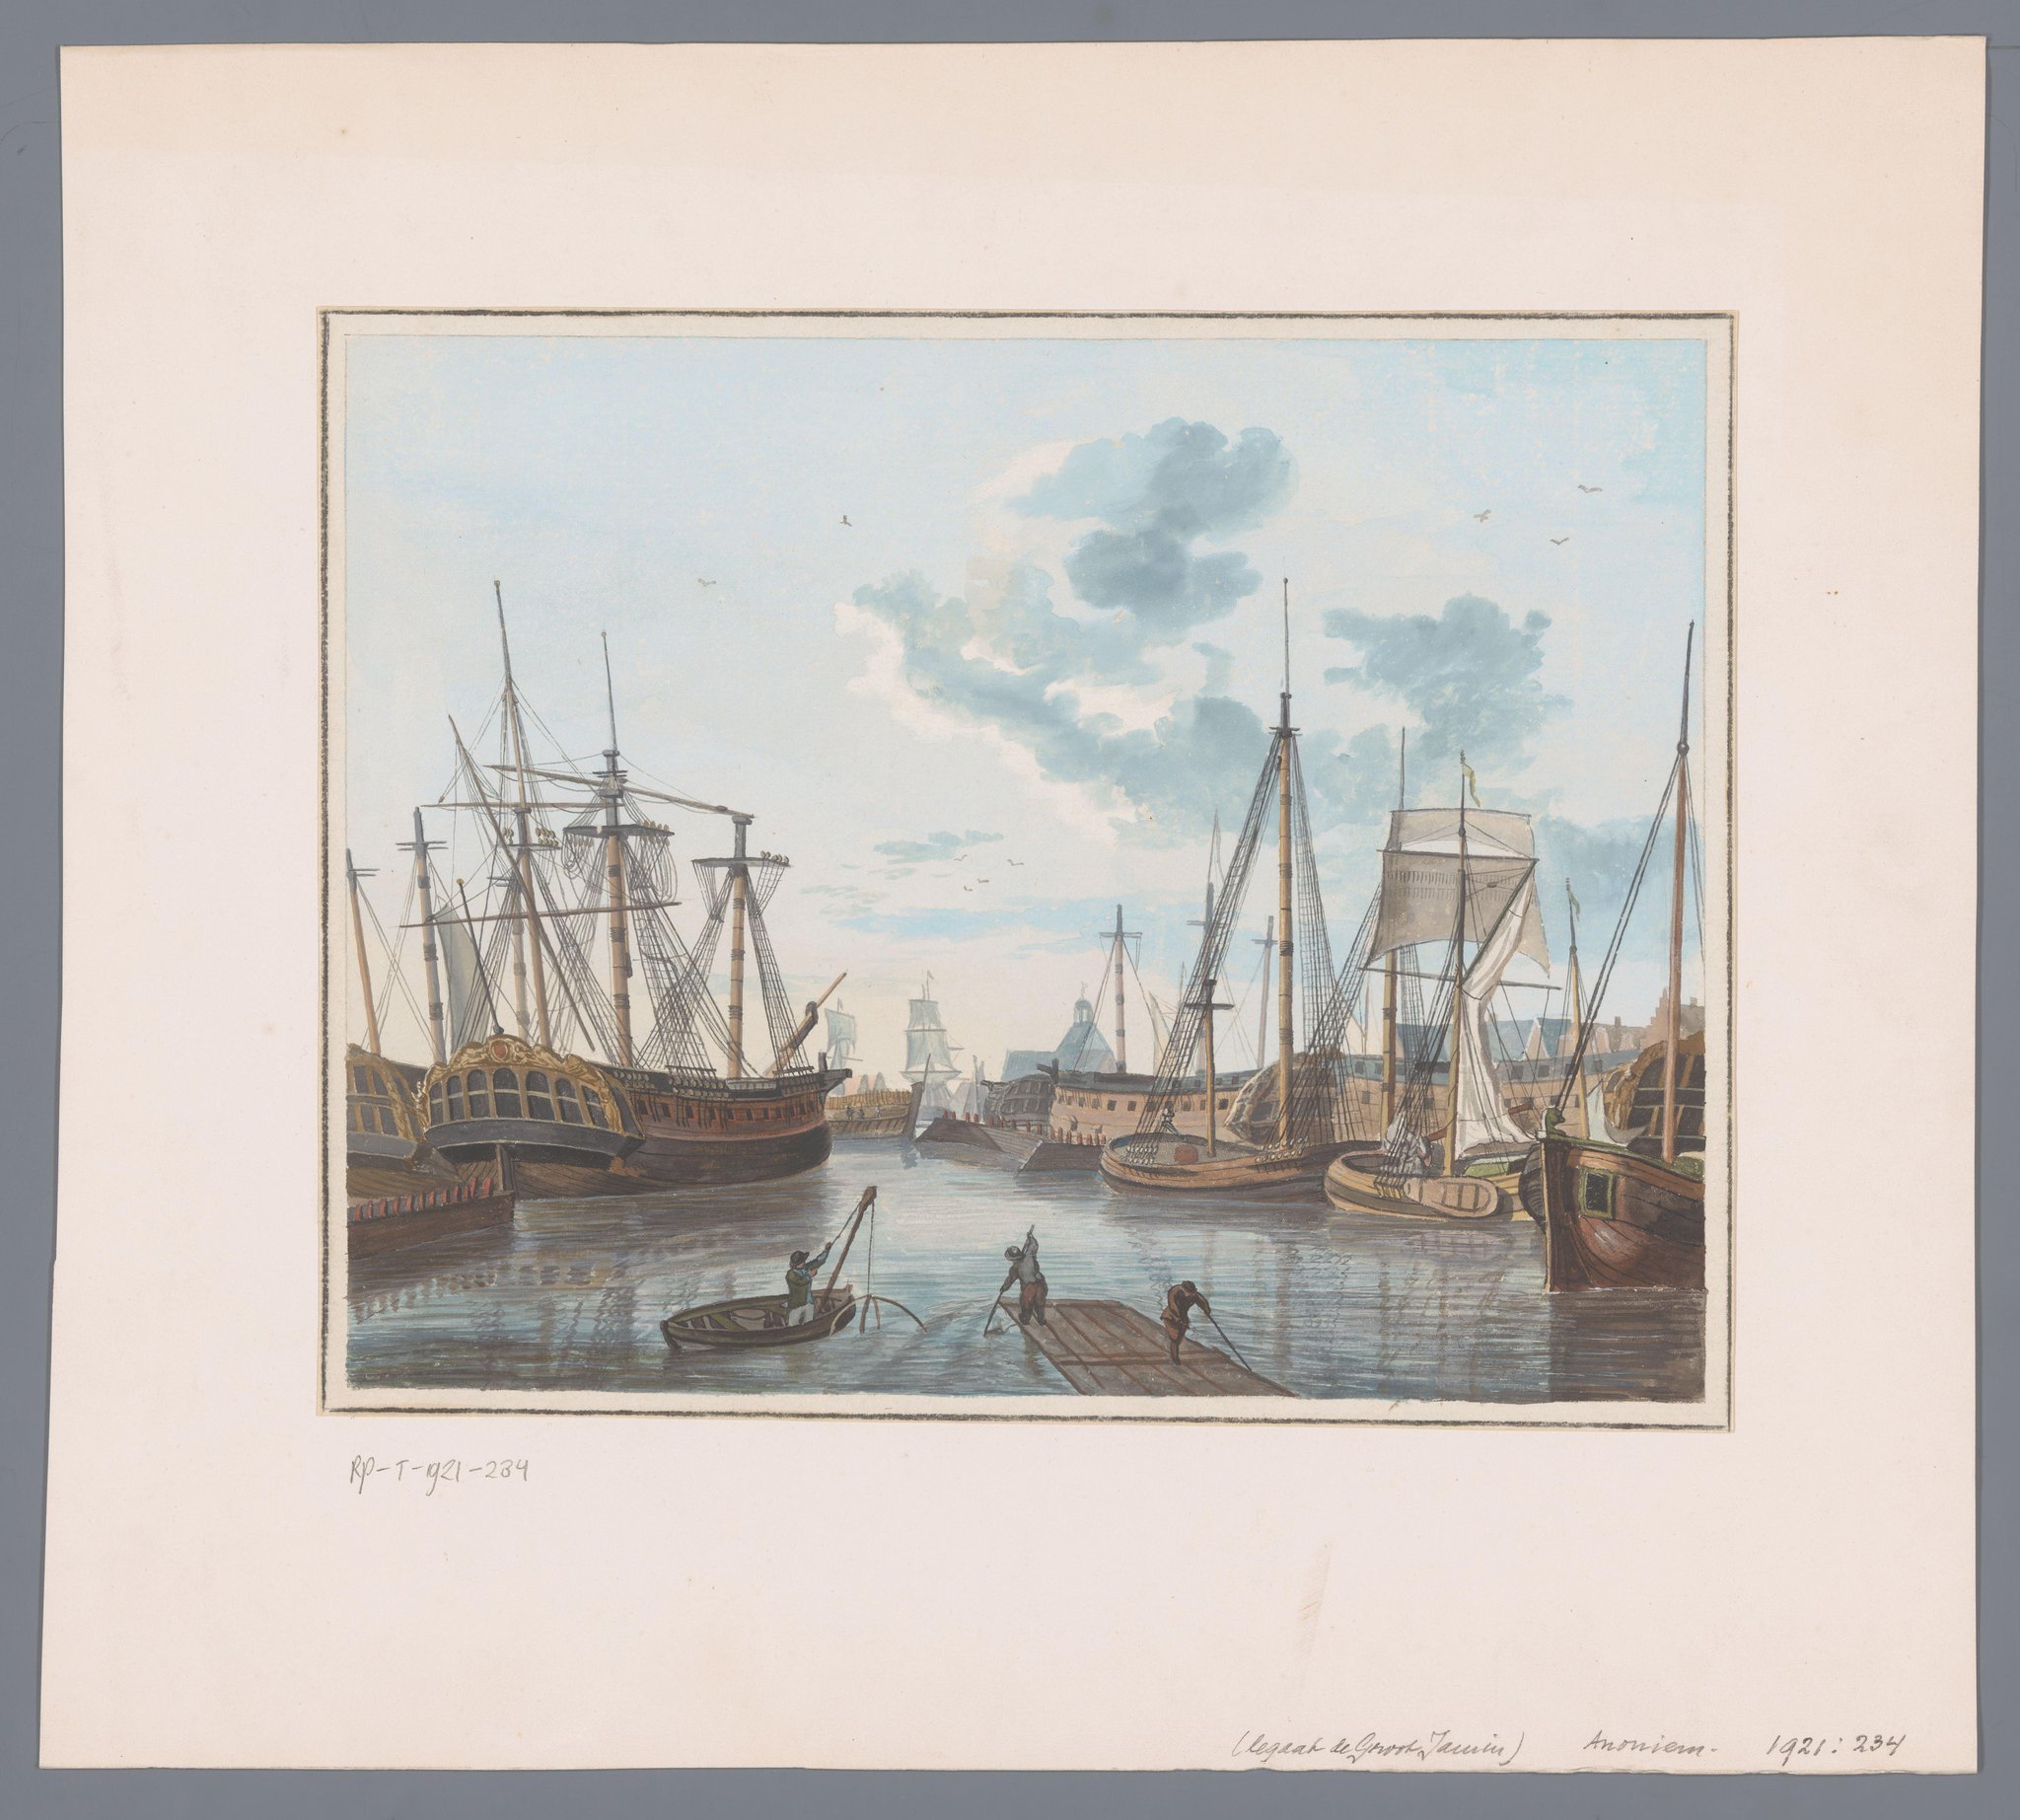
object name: book illustration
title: Lokvogel om vogels te vangen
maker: bernard picart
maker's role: draughtsman, print maker, publisher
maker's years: 1673-1733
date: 1730-1731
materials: paper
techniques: etching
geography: amsterdam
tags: bird hunting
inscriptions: collector's mark: Lugt 2233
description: Prent bedoeld voor: Chomel, Noel. Dictionnaire oeconomique, contenant divers moïens d'augmenter son bien, et de conserver sa santé. Amsterdam: Johannes Covens en Cornelis Mortier, 1732.